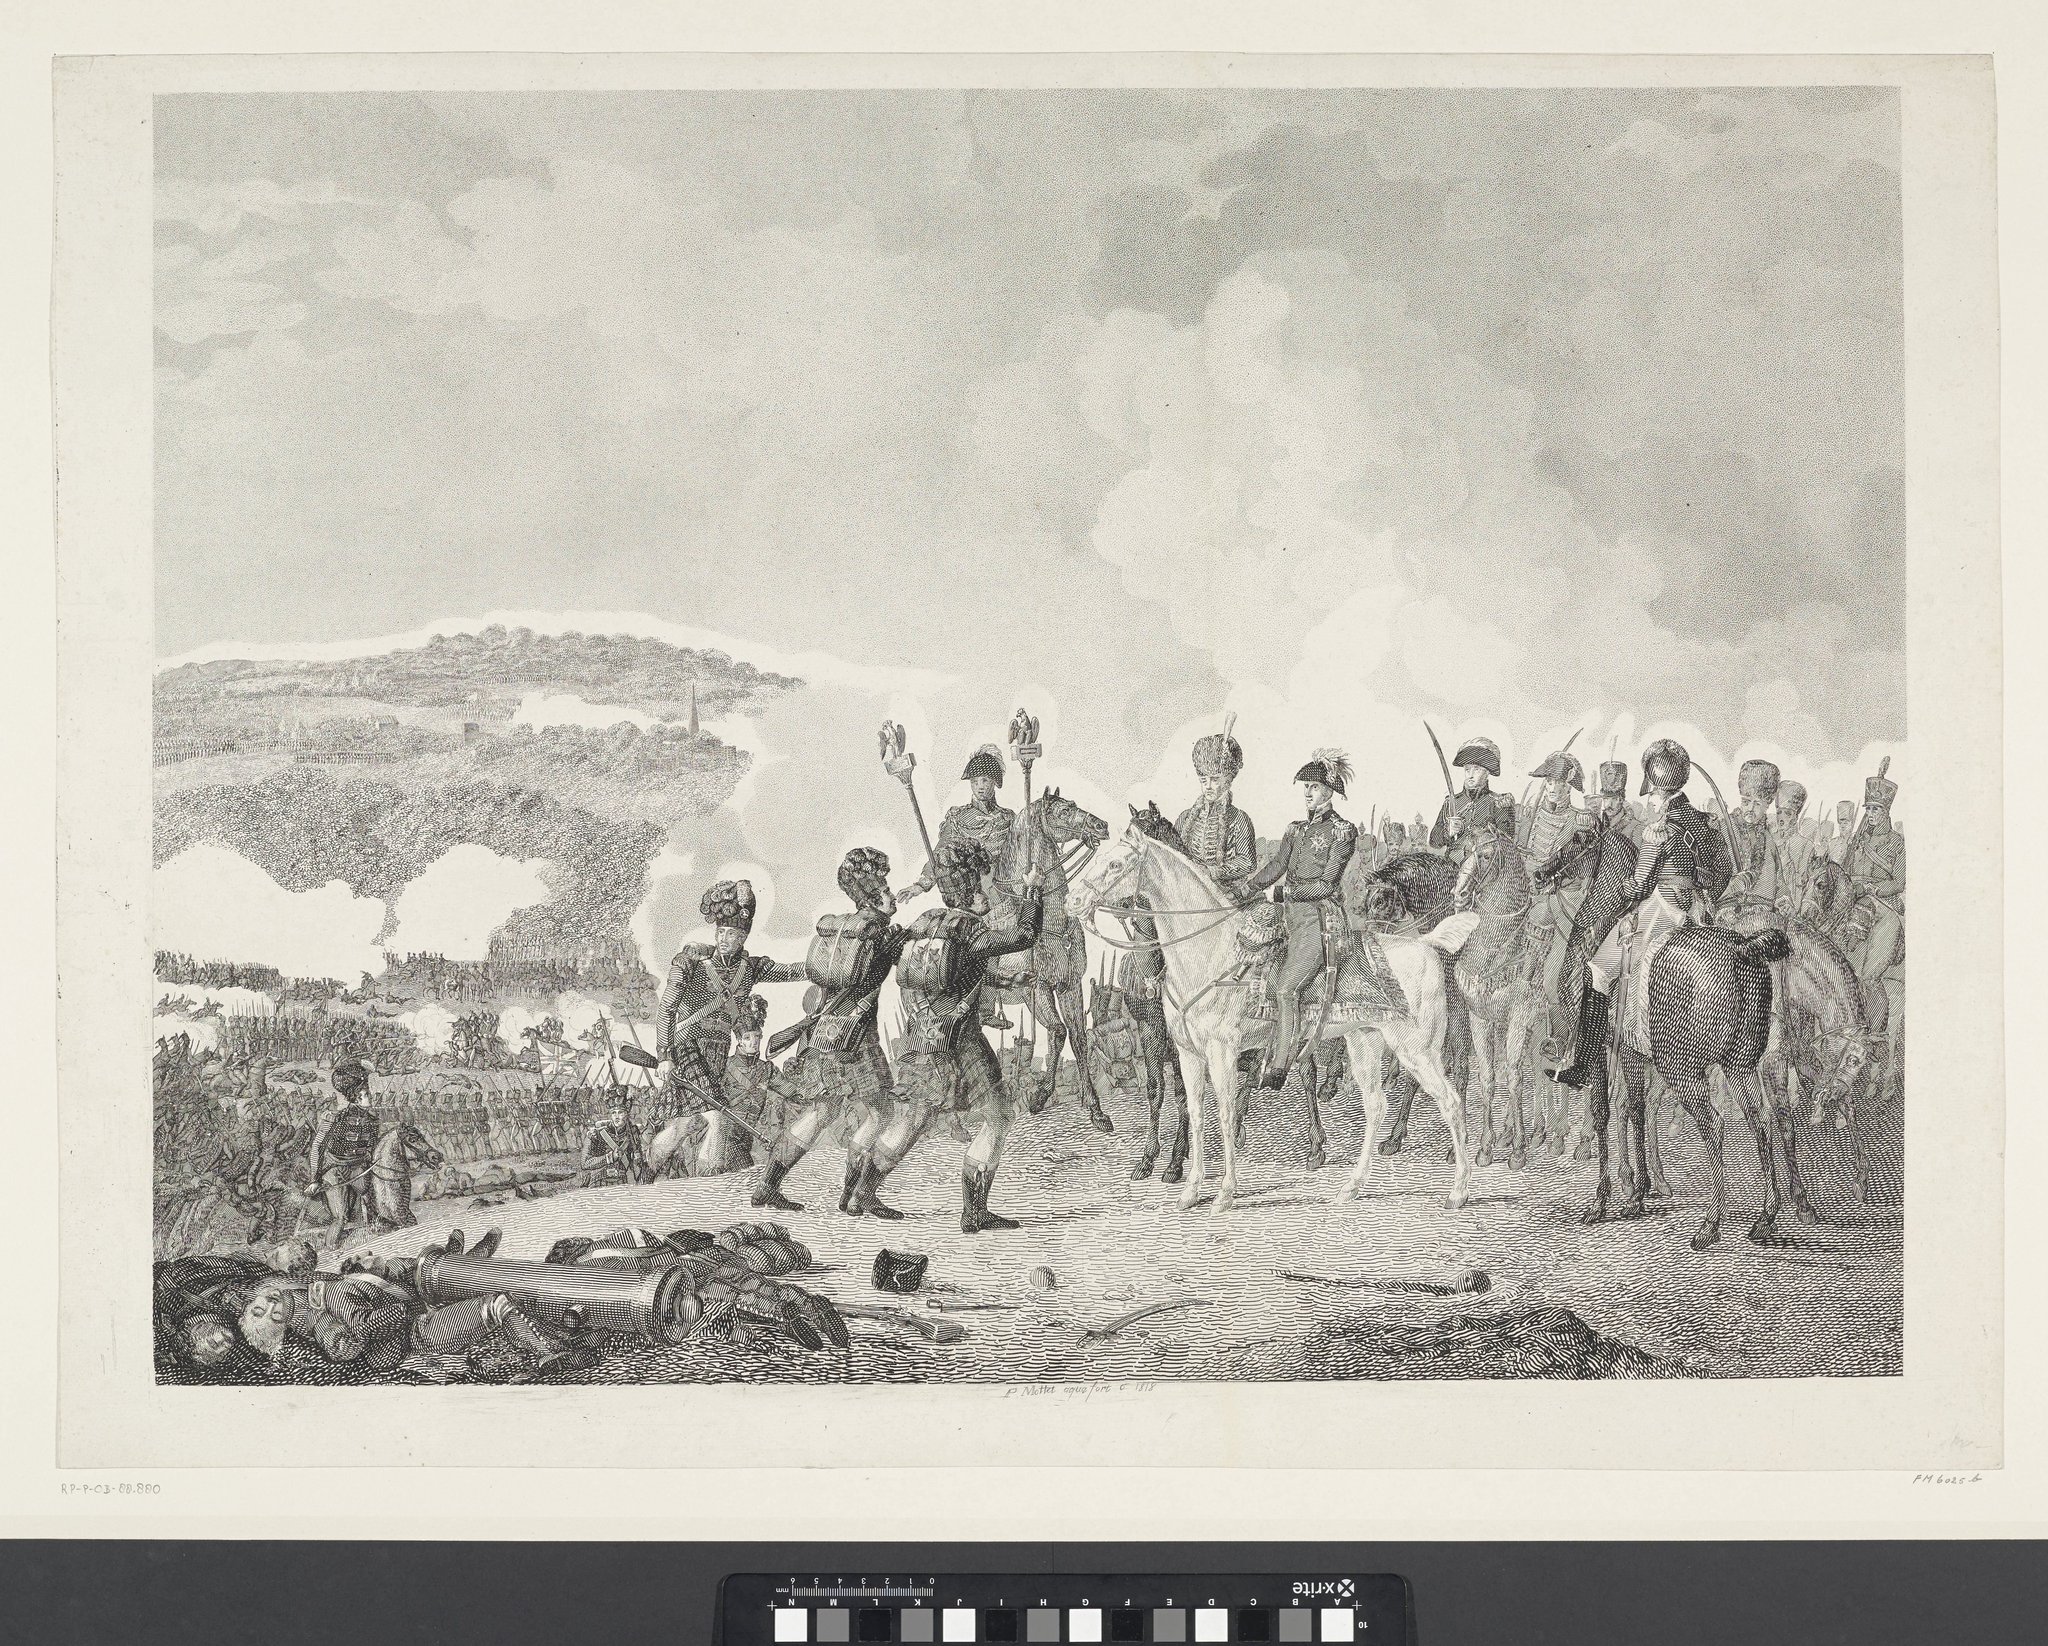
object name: print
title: Hertog van Wellington ontvangt tijdens de slag bij Waterloo twee op de Fransen veroverde standaarden met adelaars, 1815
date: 1806-1818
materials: paper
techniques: etching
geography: netherlands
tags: walmer castle, arthur wellesley of wellington, battle (+ land forces), waterloo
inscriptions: collector's mark: Lugt 2228, signature and date: ‘P Mottet aqua fort 6 1818’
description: De hertog van Wellington ontvangt van enkele Schotse militairen de tijdens de slag bij Waterloo twee op de Fransen veroverde standaarden met adelaars (zonder vaandels), 18 juni 1815. Centraal de hertog op een wit paard, omringd door zijn staf.